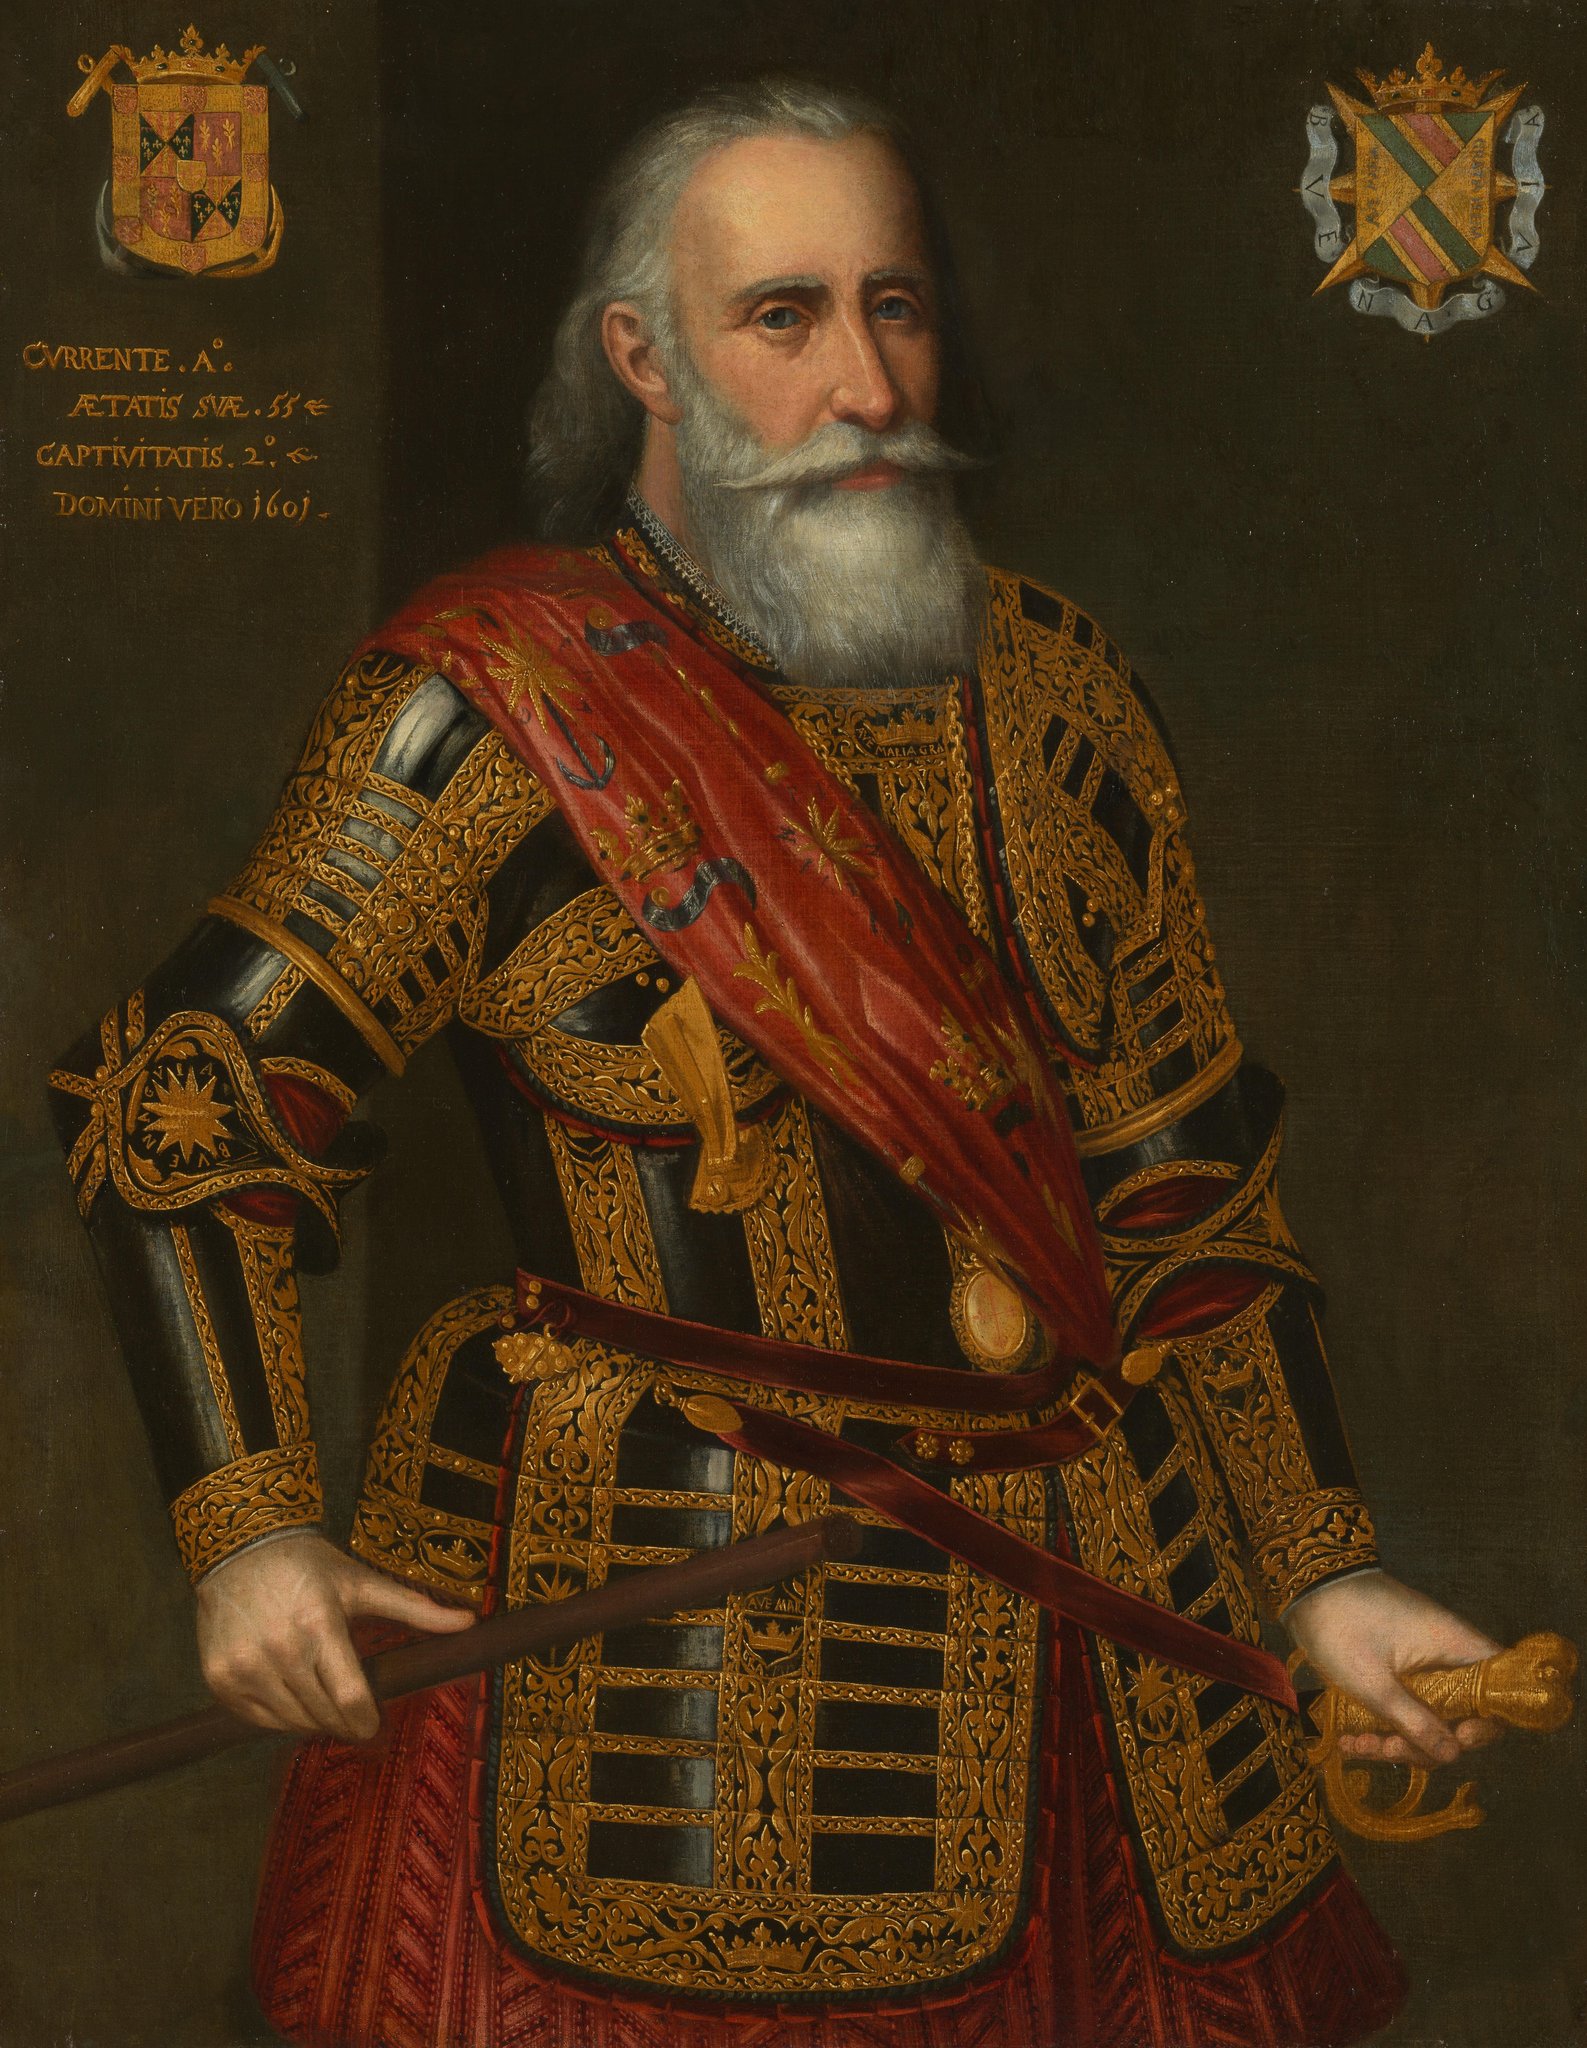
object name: painting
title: Portrait of Francisco Hurtado de Mendoza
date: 1601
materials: canvas, oil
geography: northern netherlands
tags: commander-in-chief, general, marshal, armour, historical persons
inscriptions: inscription and date: ‘Currente Aº AEtatis Suae 55 captivitatis 2º Domini Vero 1601’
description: 1600 – the Battle of Nieuwpoort. A familiar date for many Dutch people. The Dutch States and Spanish armies meet on the beach near Nieuwpoort in Flanders. Maurice wins narrowly. The Spanish general Mendoza is removed to the Republic as a prisoner of war. An embarrassing situation and a major loss of face. And yet while in captivity Mendoza has himself portrayed in full regalia and with befitting dignity by a Dutch artist.